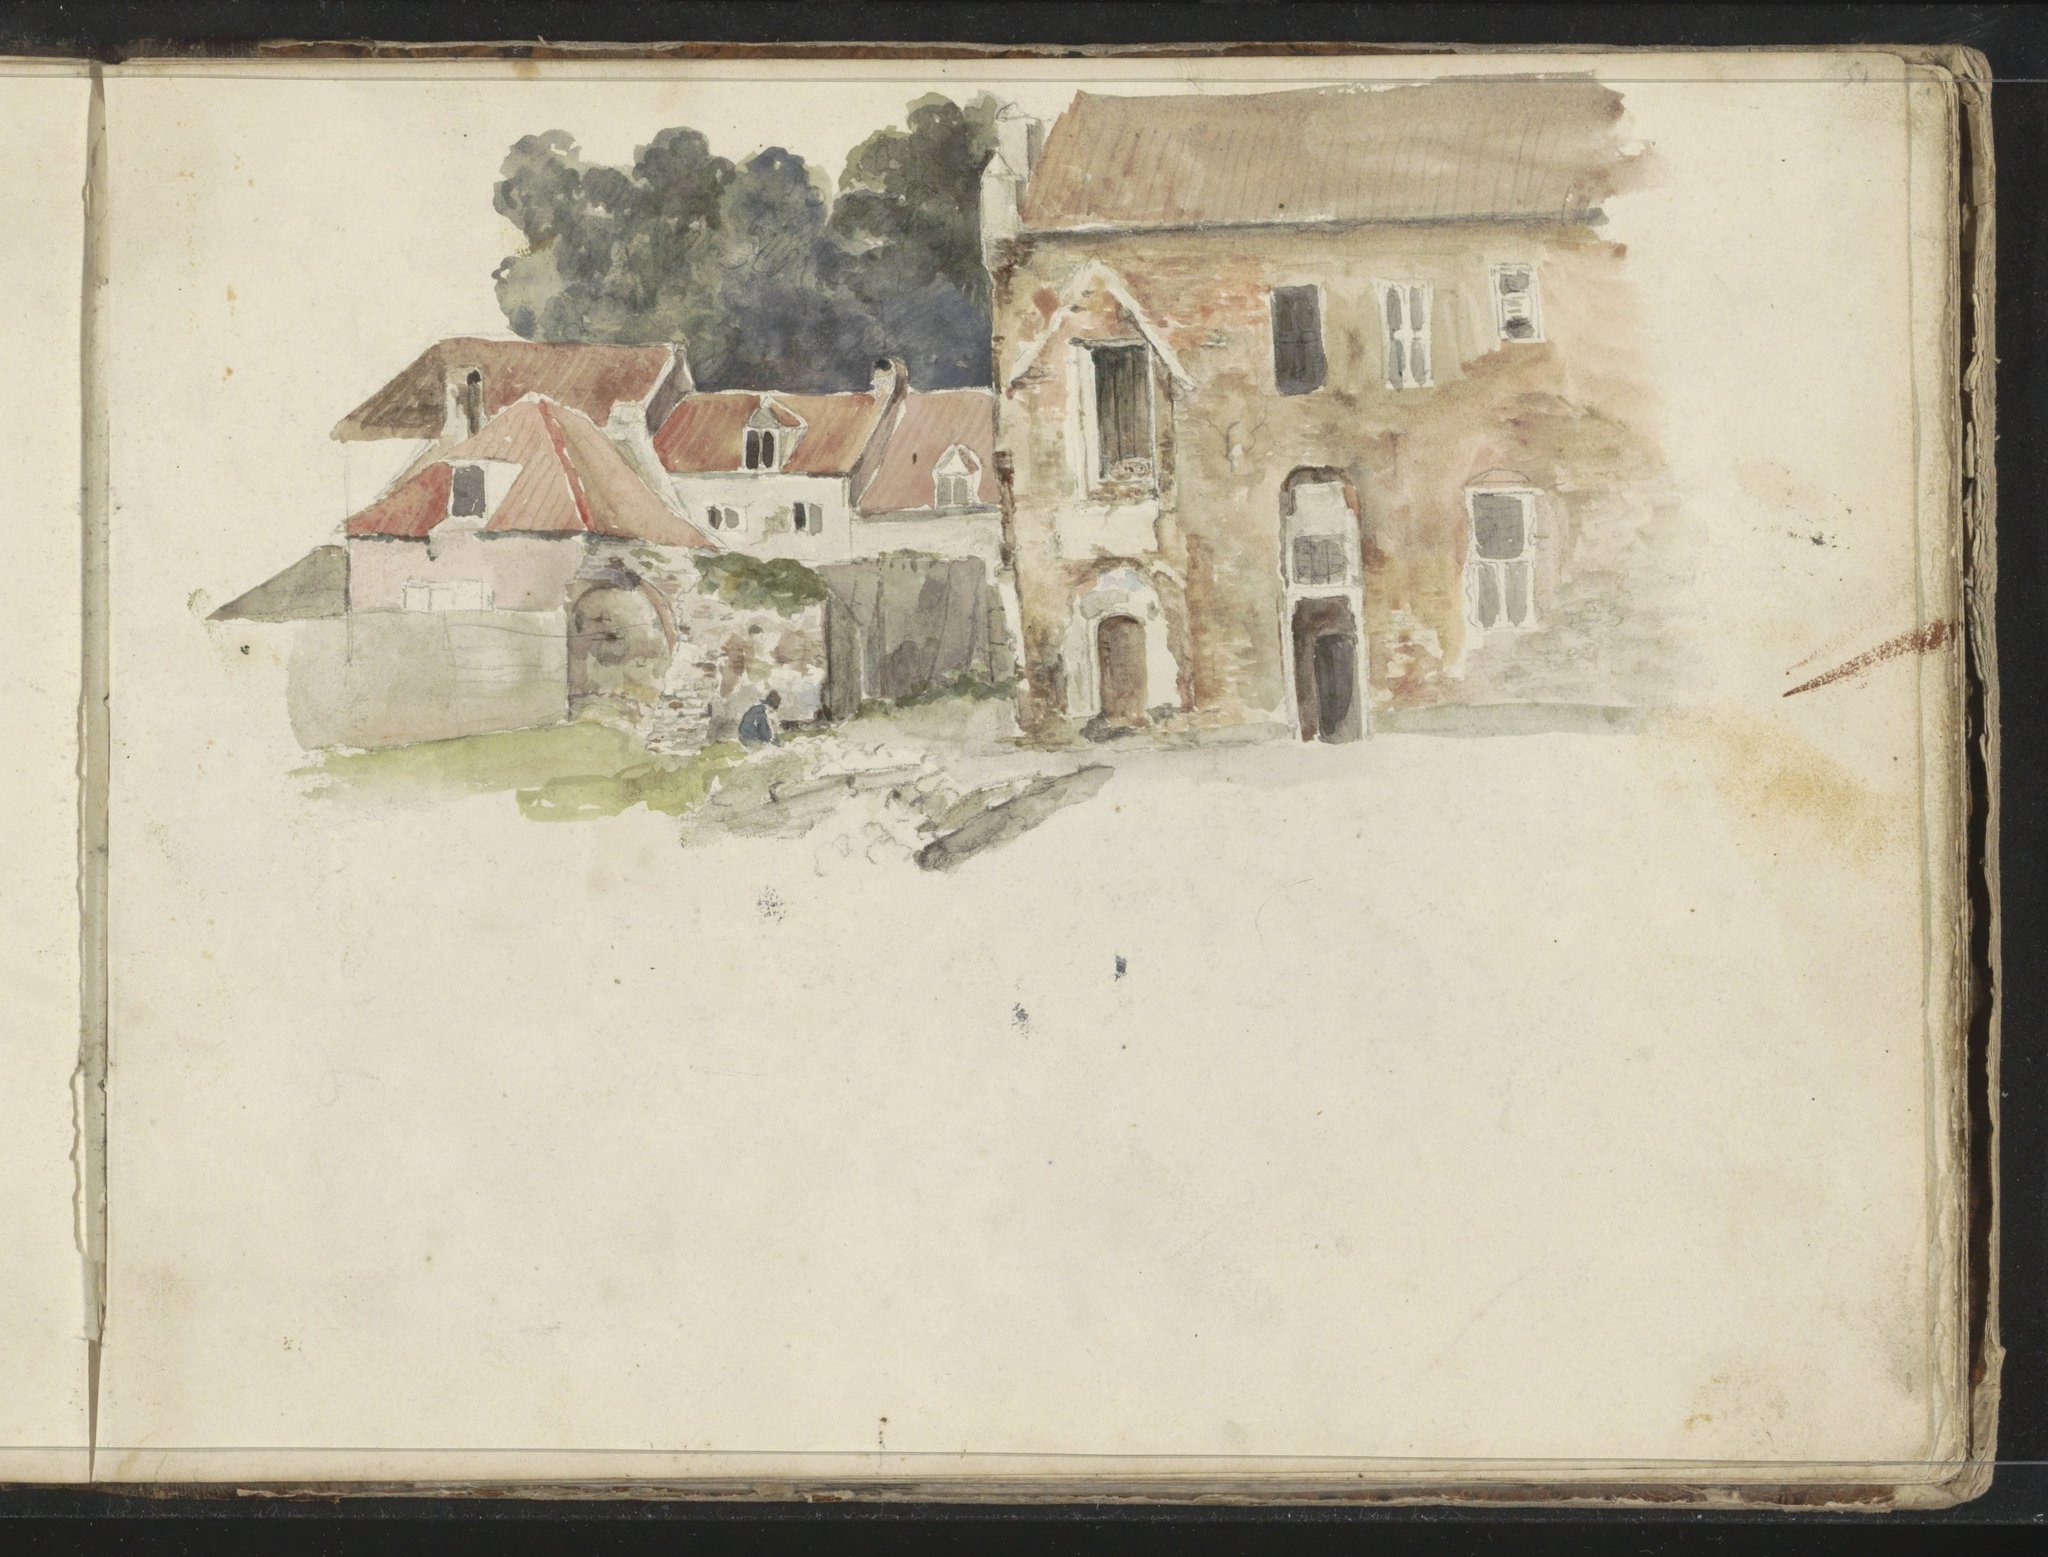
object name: sketchbook leaf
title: Figuur op een stuk grond tussen de huizen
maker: willem troost (ii)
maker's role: draughtsman, painter, print maker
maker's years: 1812-1893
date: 1822-1893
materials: paper, pencil, watercolor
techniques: brush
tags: rural housing, e.g. country-house, villa, cottage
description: Blad 51 recto uit een schetsboek met 36 bladen.